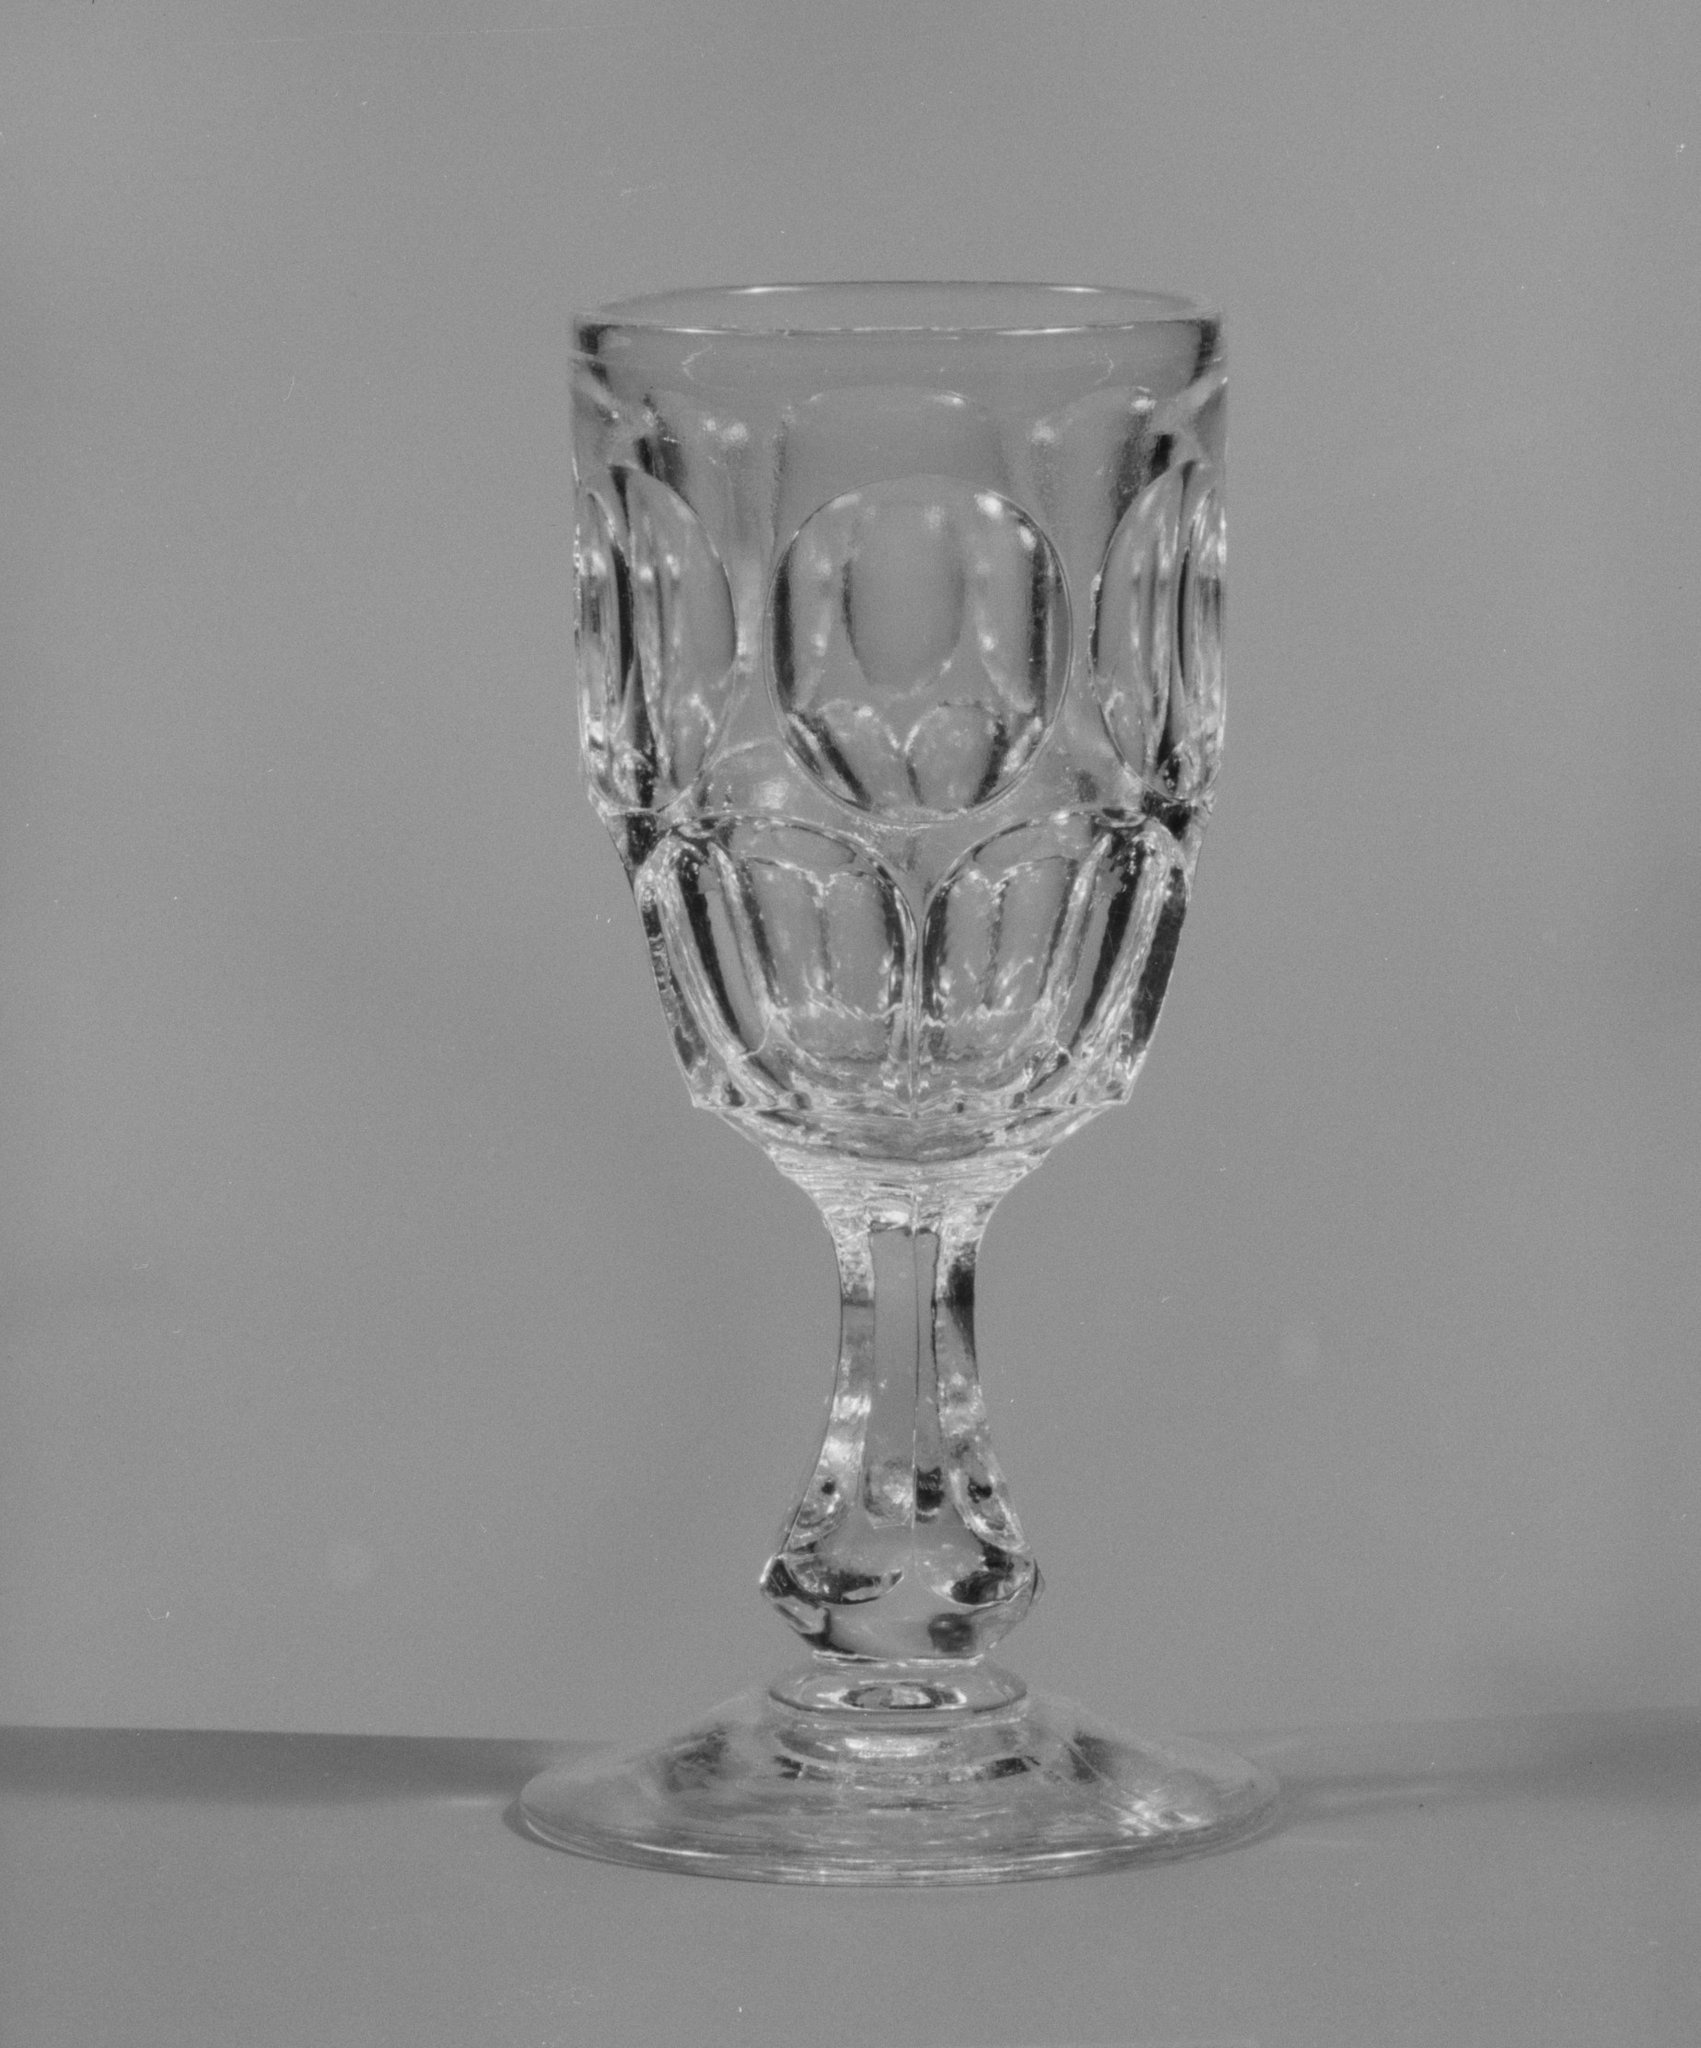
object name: cordial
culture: american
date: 1800-1900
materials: glass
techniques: pressed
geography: united states